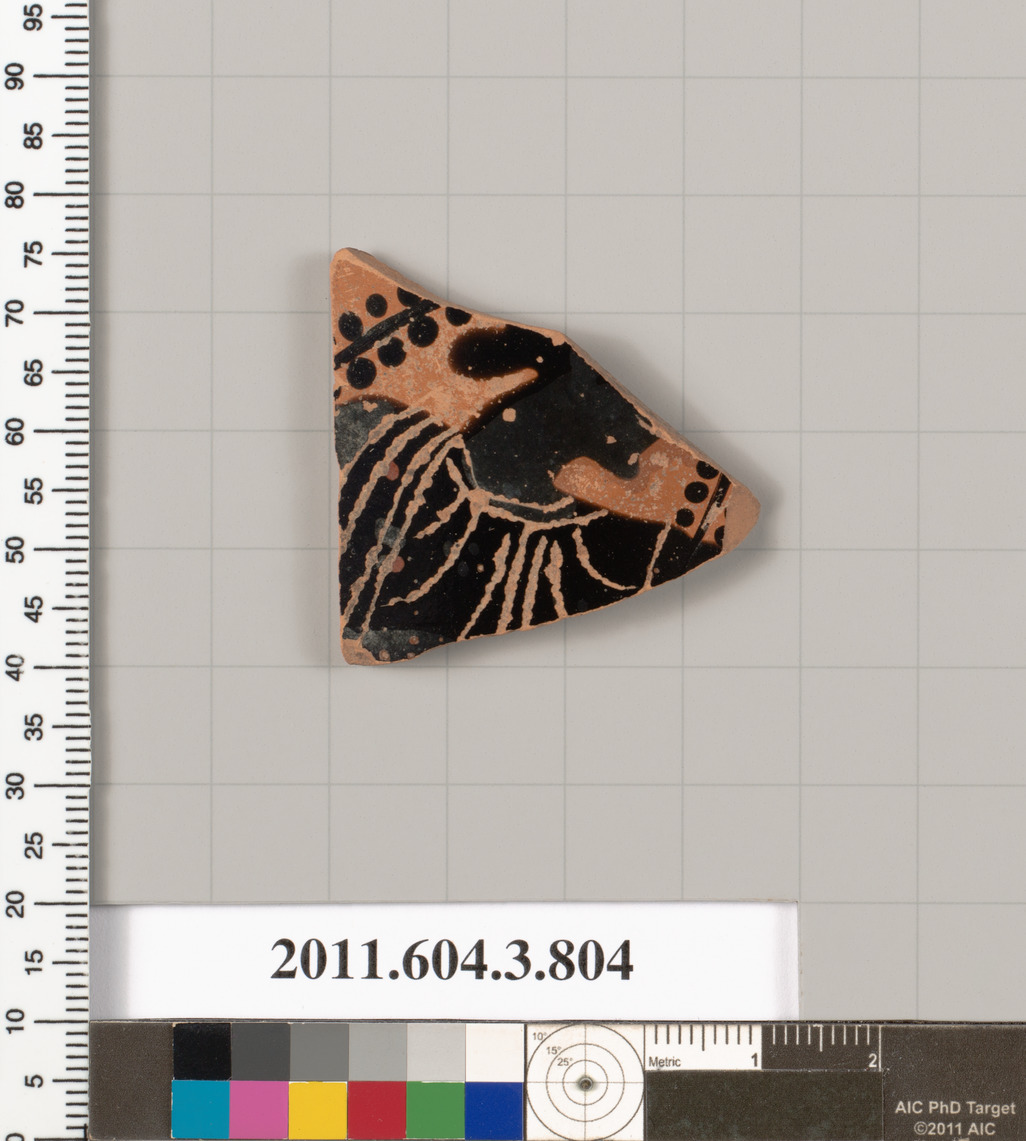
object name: lekythos fragment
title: Terracotta fragment of a lekythos (oil flask)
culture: greek, attic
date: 534-501 BCE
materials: terracotta